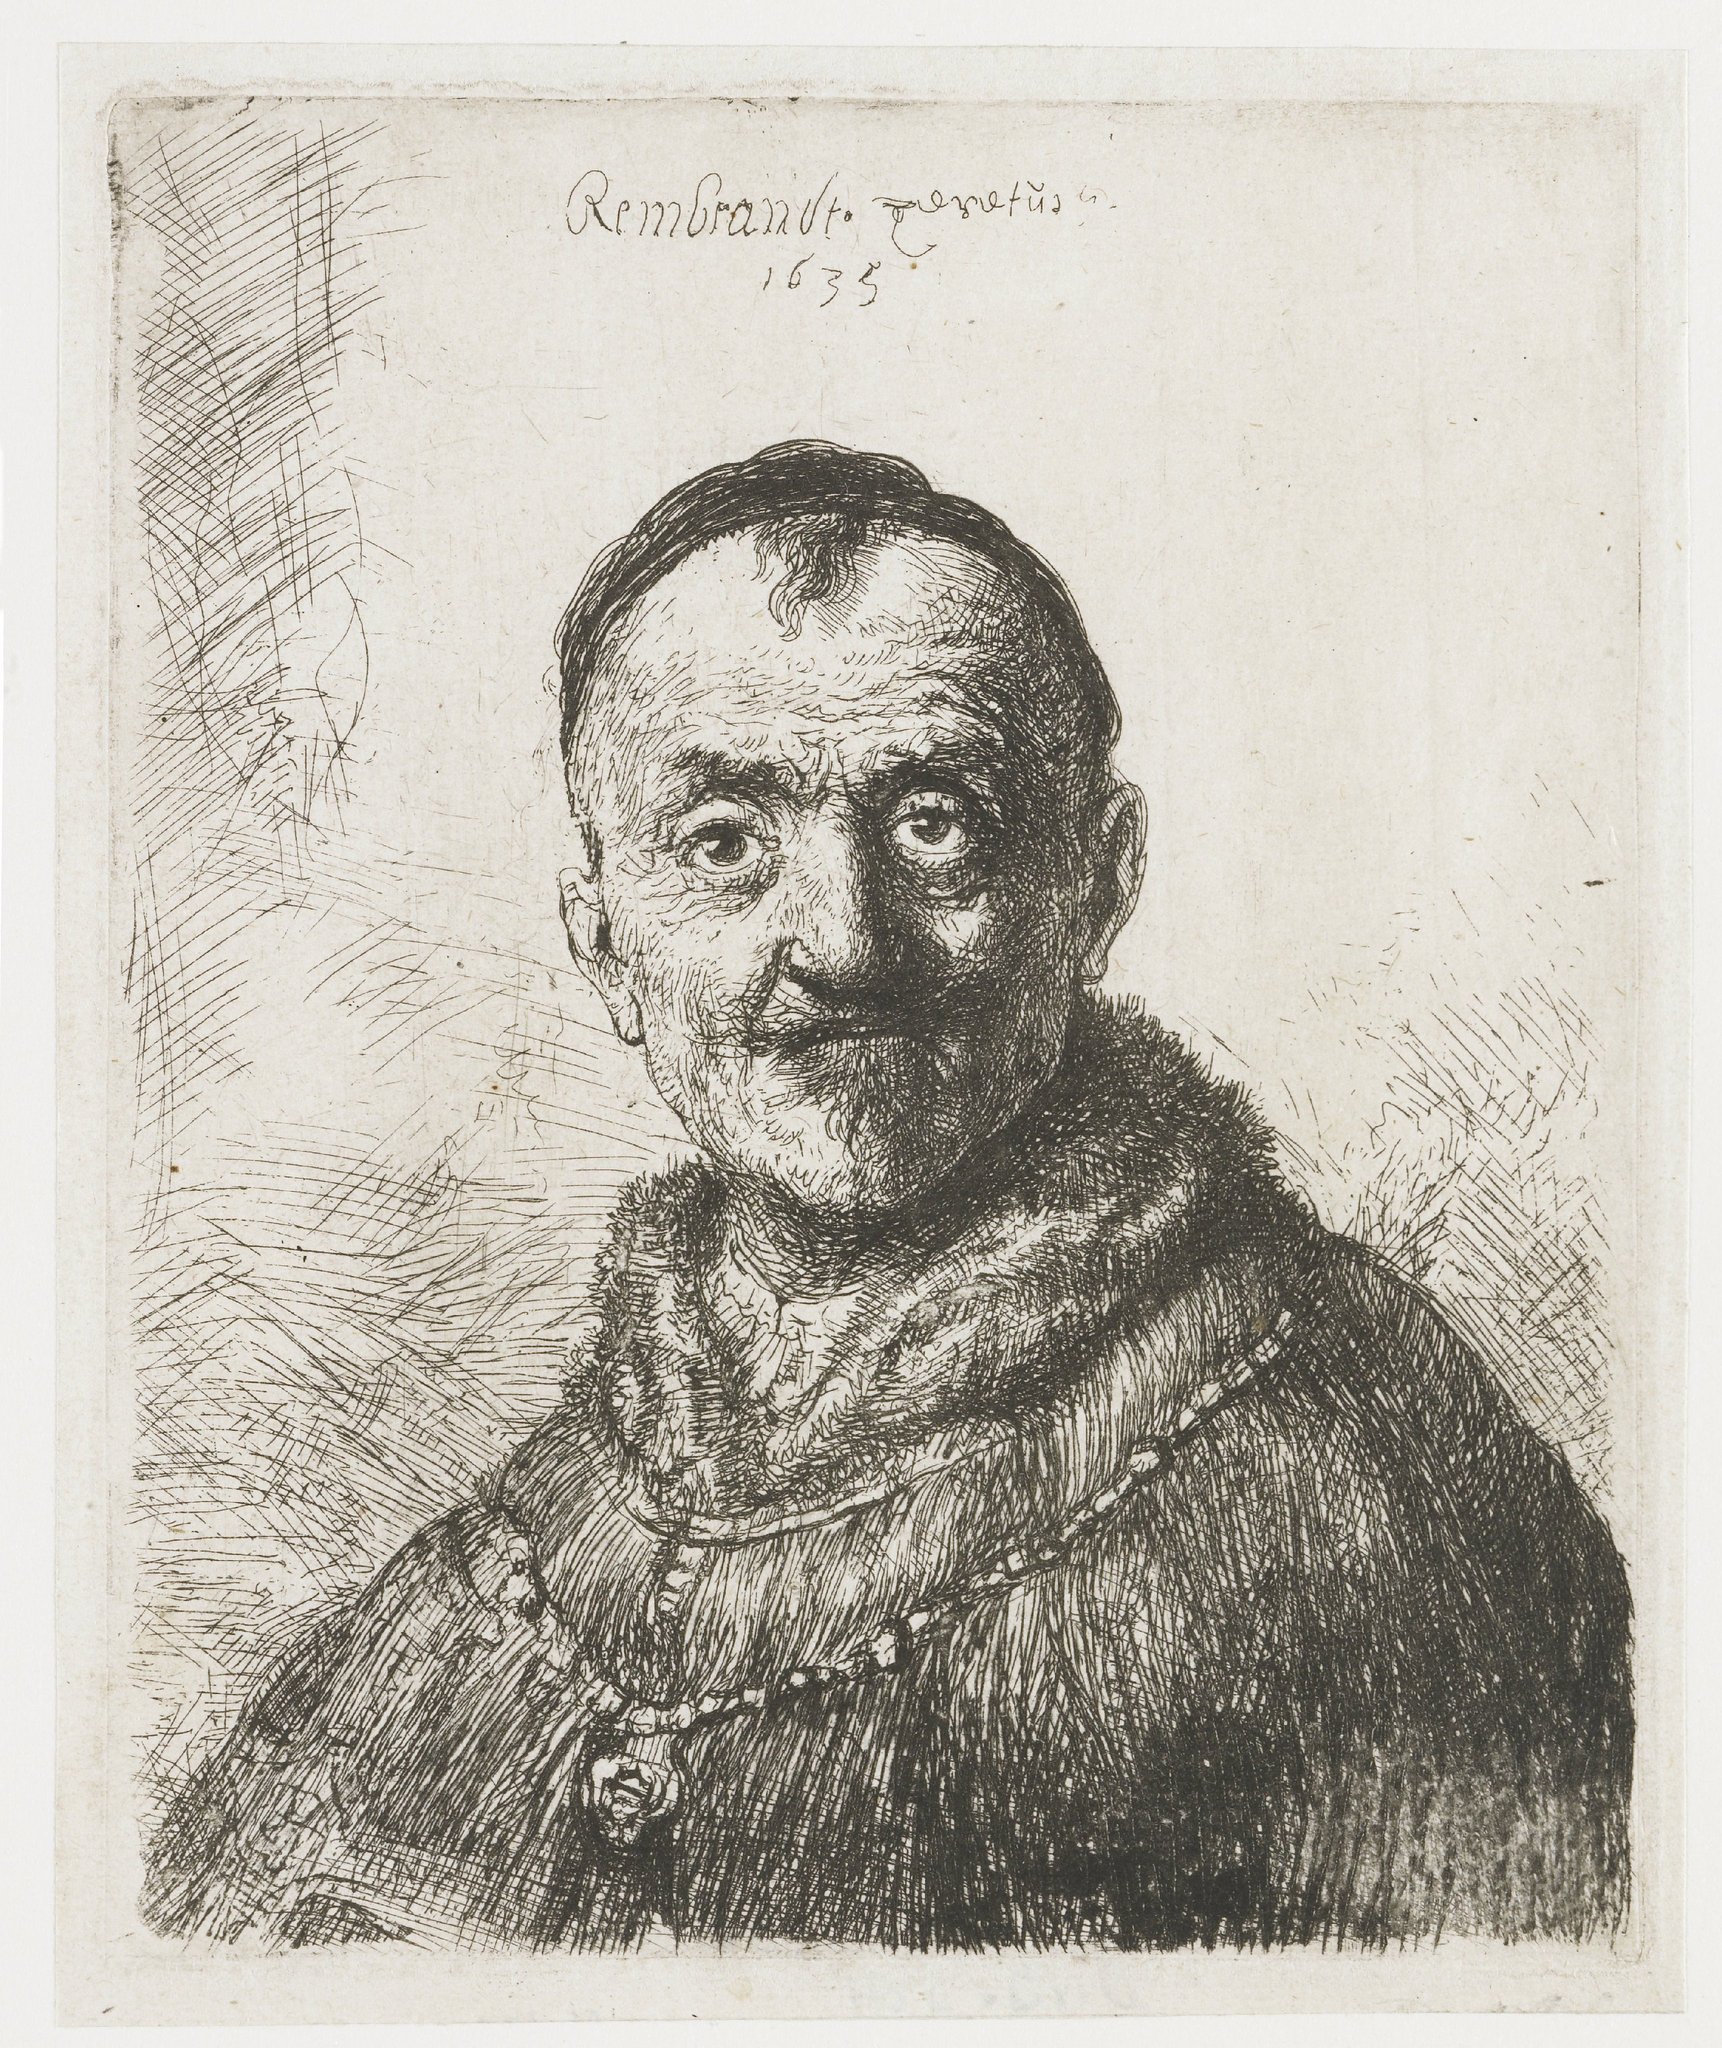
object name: print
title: The first Oriental head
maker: rembrandt van rijn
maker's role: draughtsman, painter, print maker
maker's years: 1606-1669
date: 1635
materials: paper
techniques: drypoint, etching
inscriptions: mark: Lugt 699, inscription: ‘niet dubbel’, mark: Lugt 2228 a, signature and date: ‘Rembrandt geretuc 1635’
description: This set of etchings is traditionally called the ‘Four Oriental Heads’. Rembrandt did not etch them from life, but rather after prints his Leiden friend and colleague Jan Lievens made around 1631. He did not do this simply because he admired Lievens’s work. On three of the four prints, Rembrandt noted that he had geretuckeerd (meaning both adapted and improved) them.